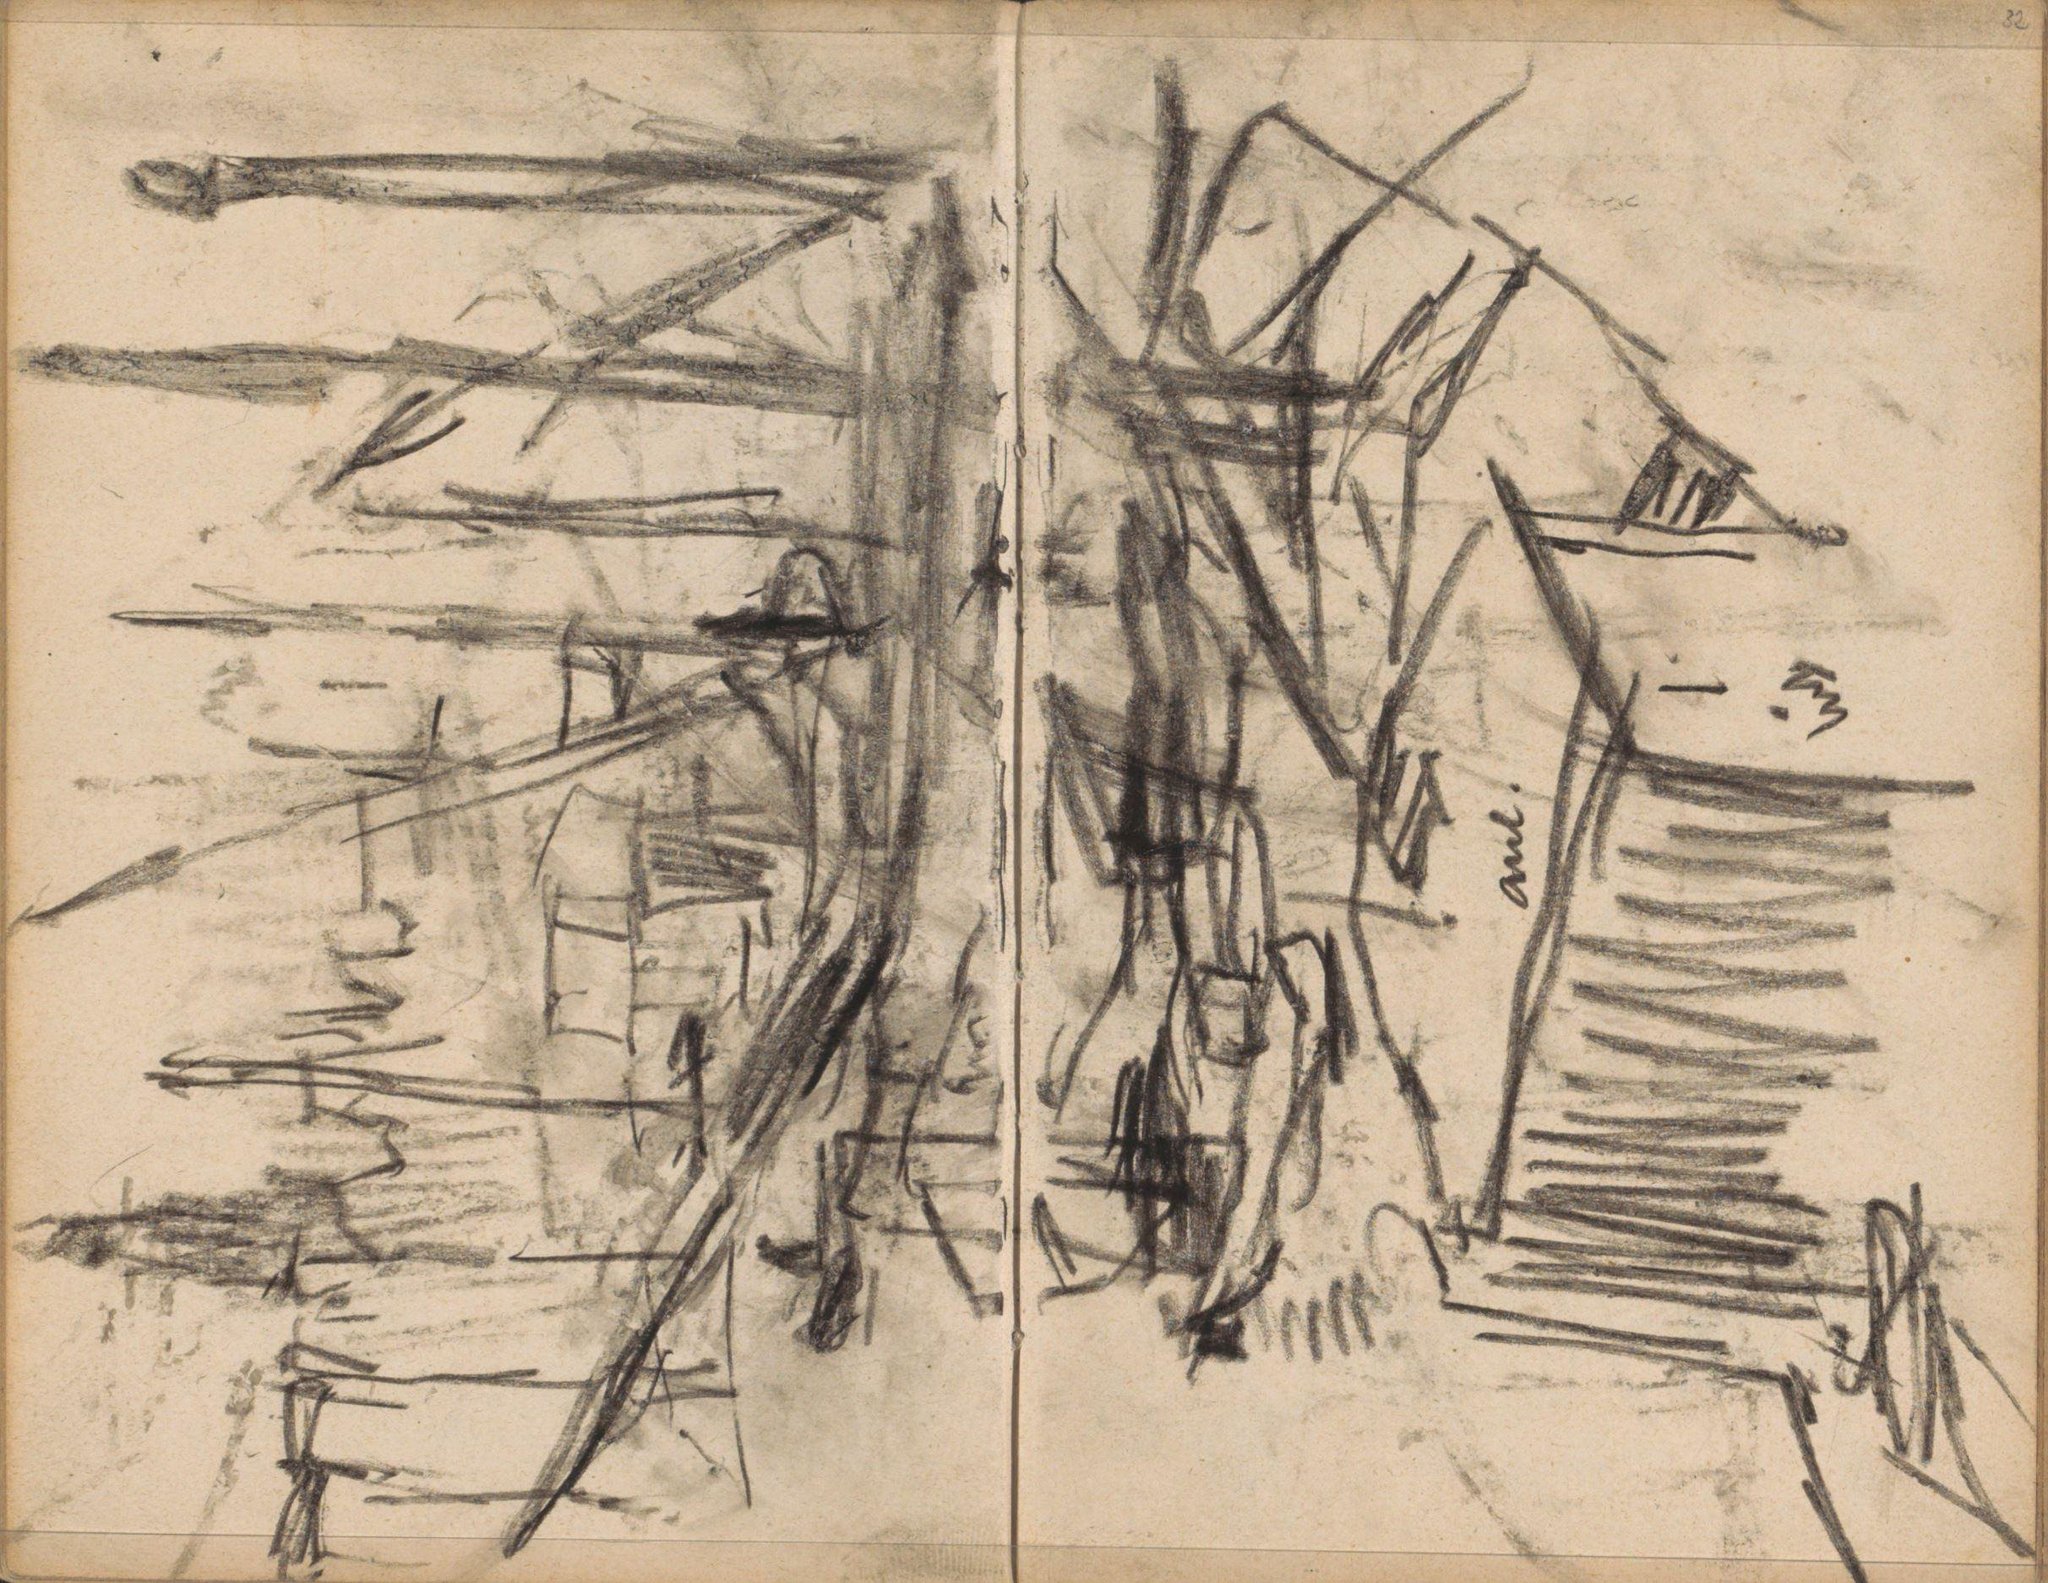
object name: sketchbook leaf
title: Gezicht op het Damrak met de toren van de Oude Kerk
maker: george hendrik breitner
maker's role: draughtsman, painter, print maker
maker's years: 1857-1923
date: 1903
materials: chalk, paper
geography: amsterdam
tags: urban housing, canals, waters (in city), parts of church exterior and annexes: tower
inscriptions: kleurnotitie, handgeschreven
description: Gezicht op het Damrak met de toren van de Oude Kerk. Pagina 31 en pagina 32 uit een schetsboek met 46 bladen vervaardigd te Amsterdam en Haarlem.